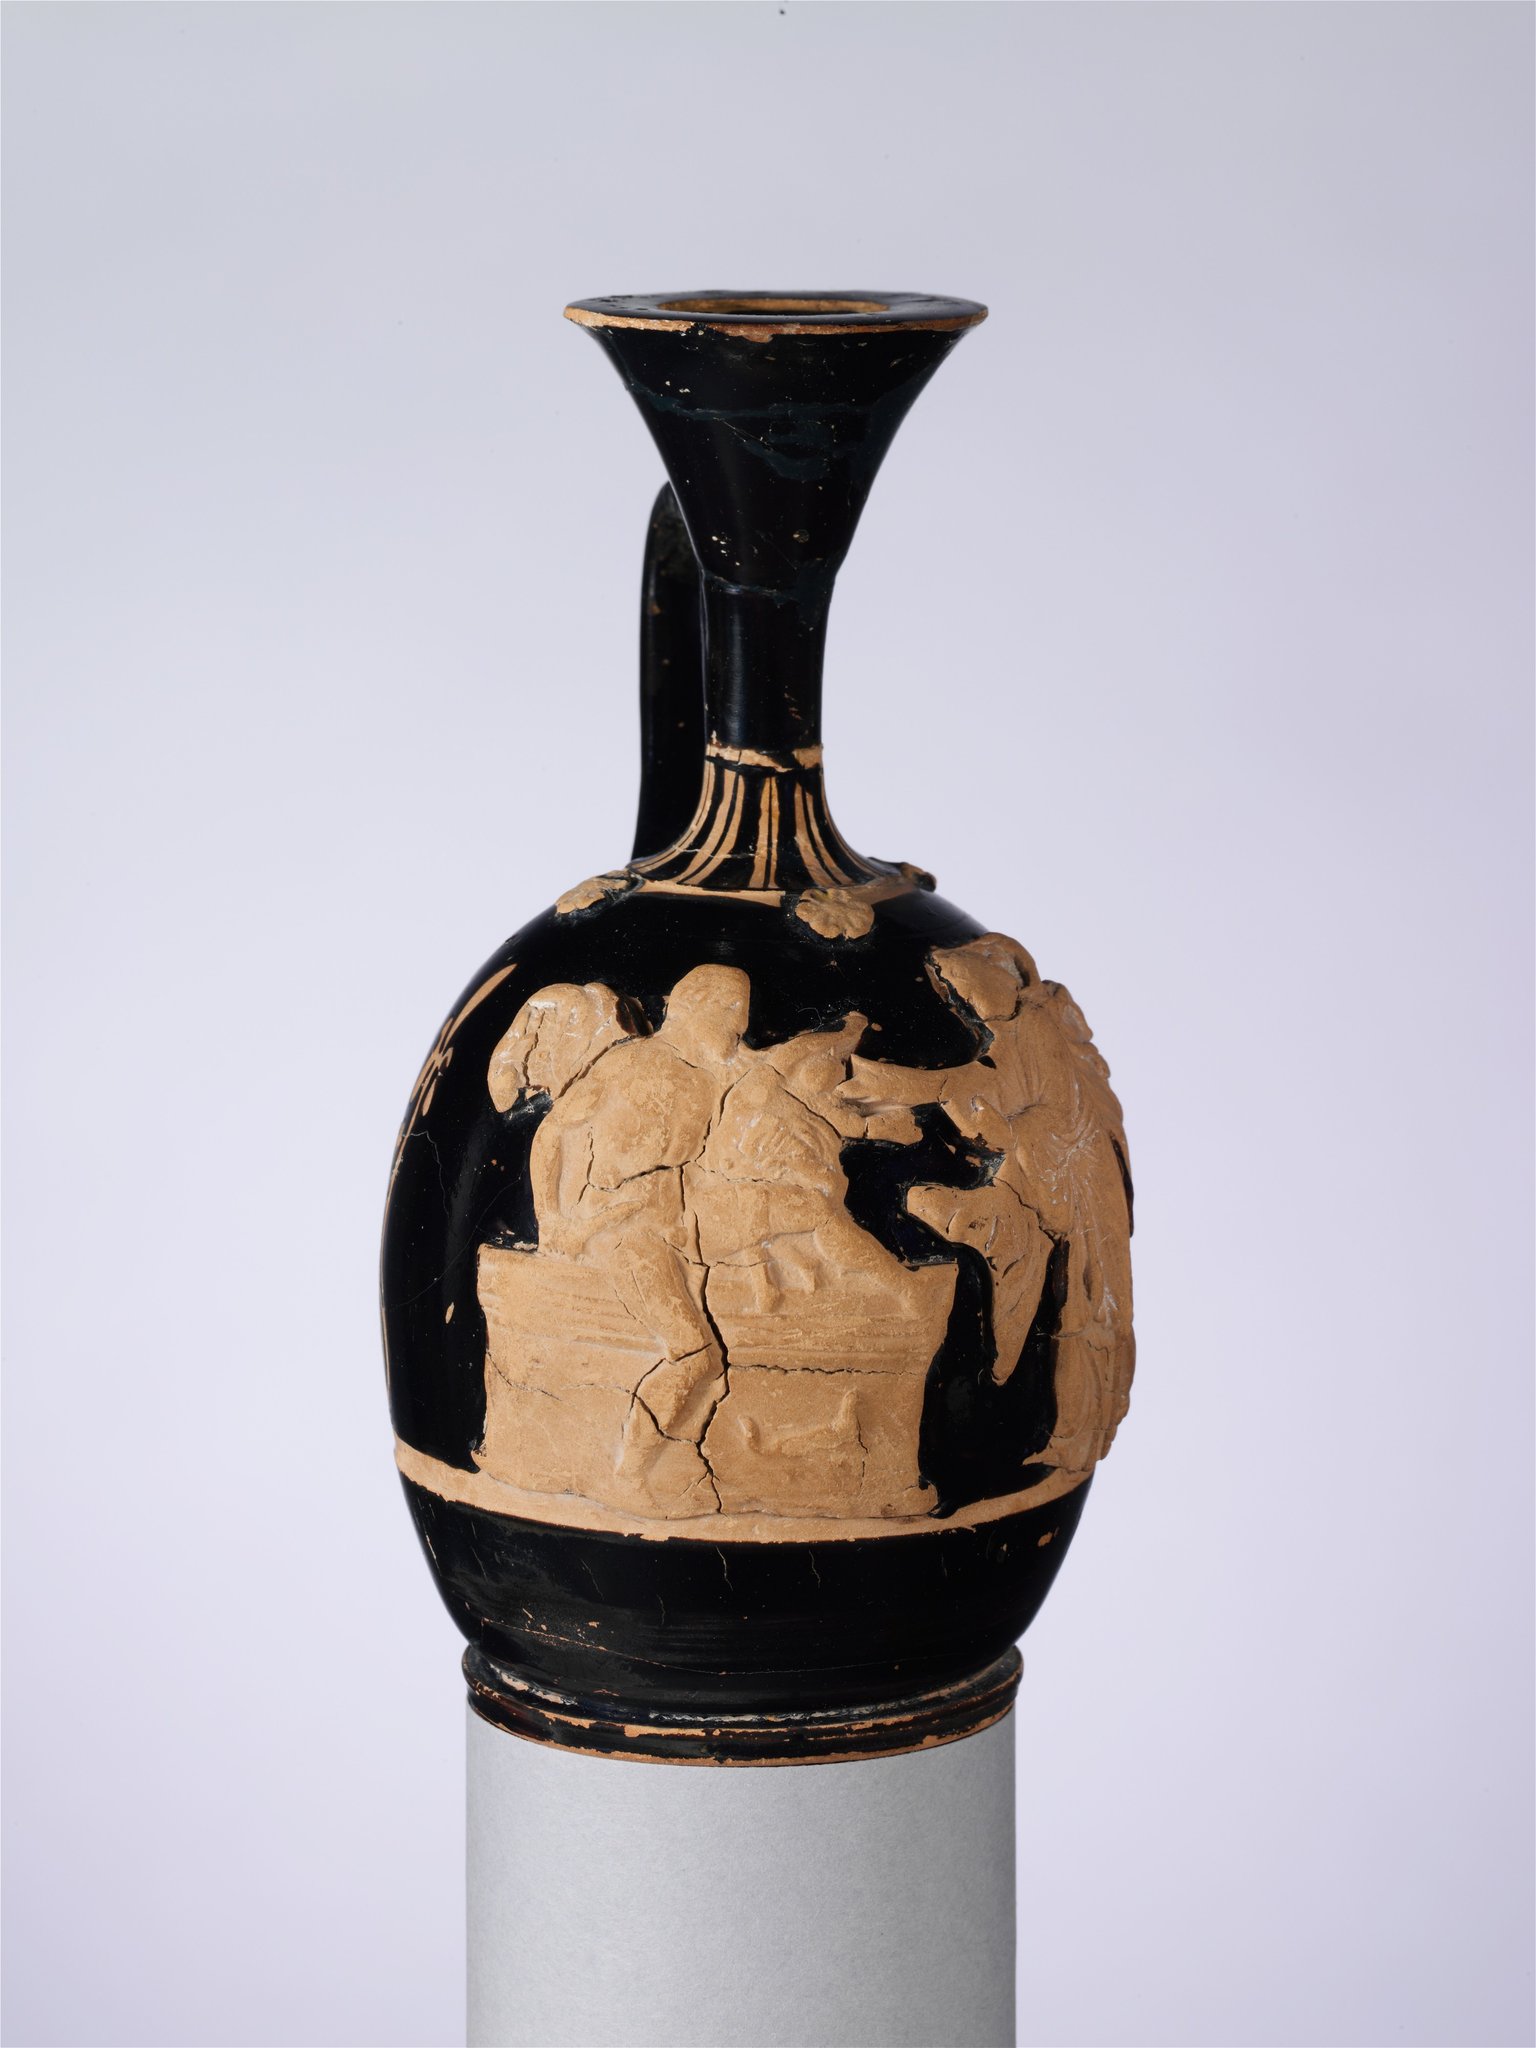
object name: squat lekythos with relief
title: Terracotta lekythos (oil flask)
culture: greek, attic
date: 334-301 BCE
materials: terracotta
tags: clytemnestra